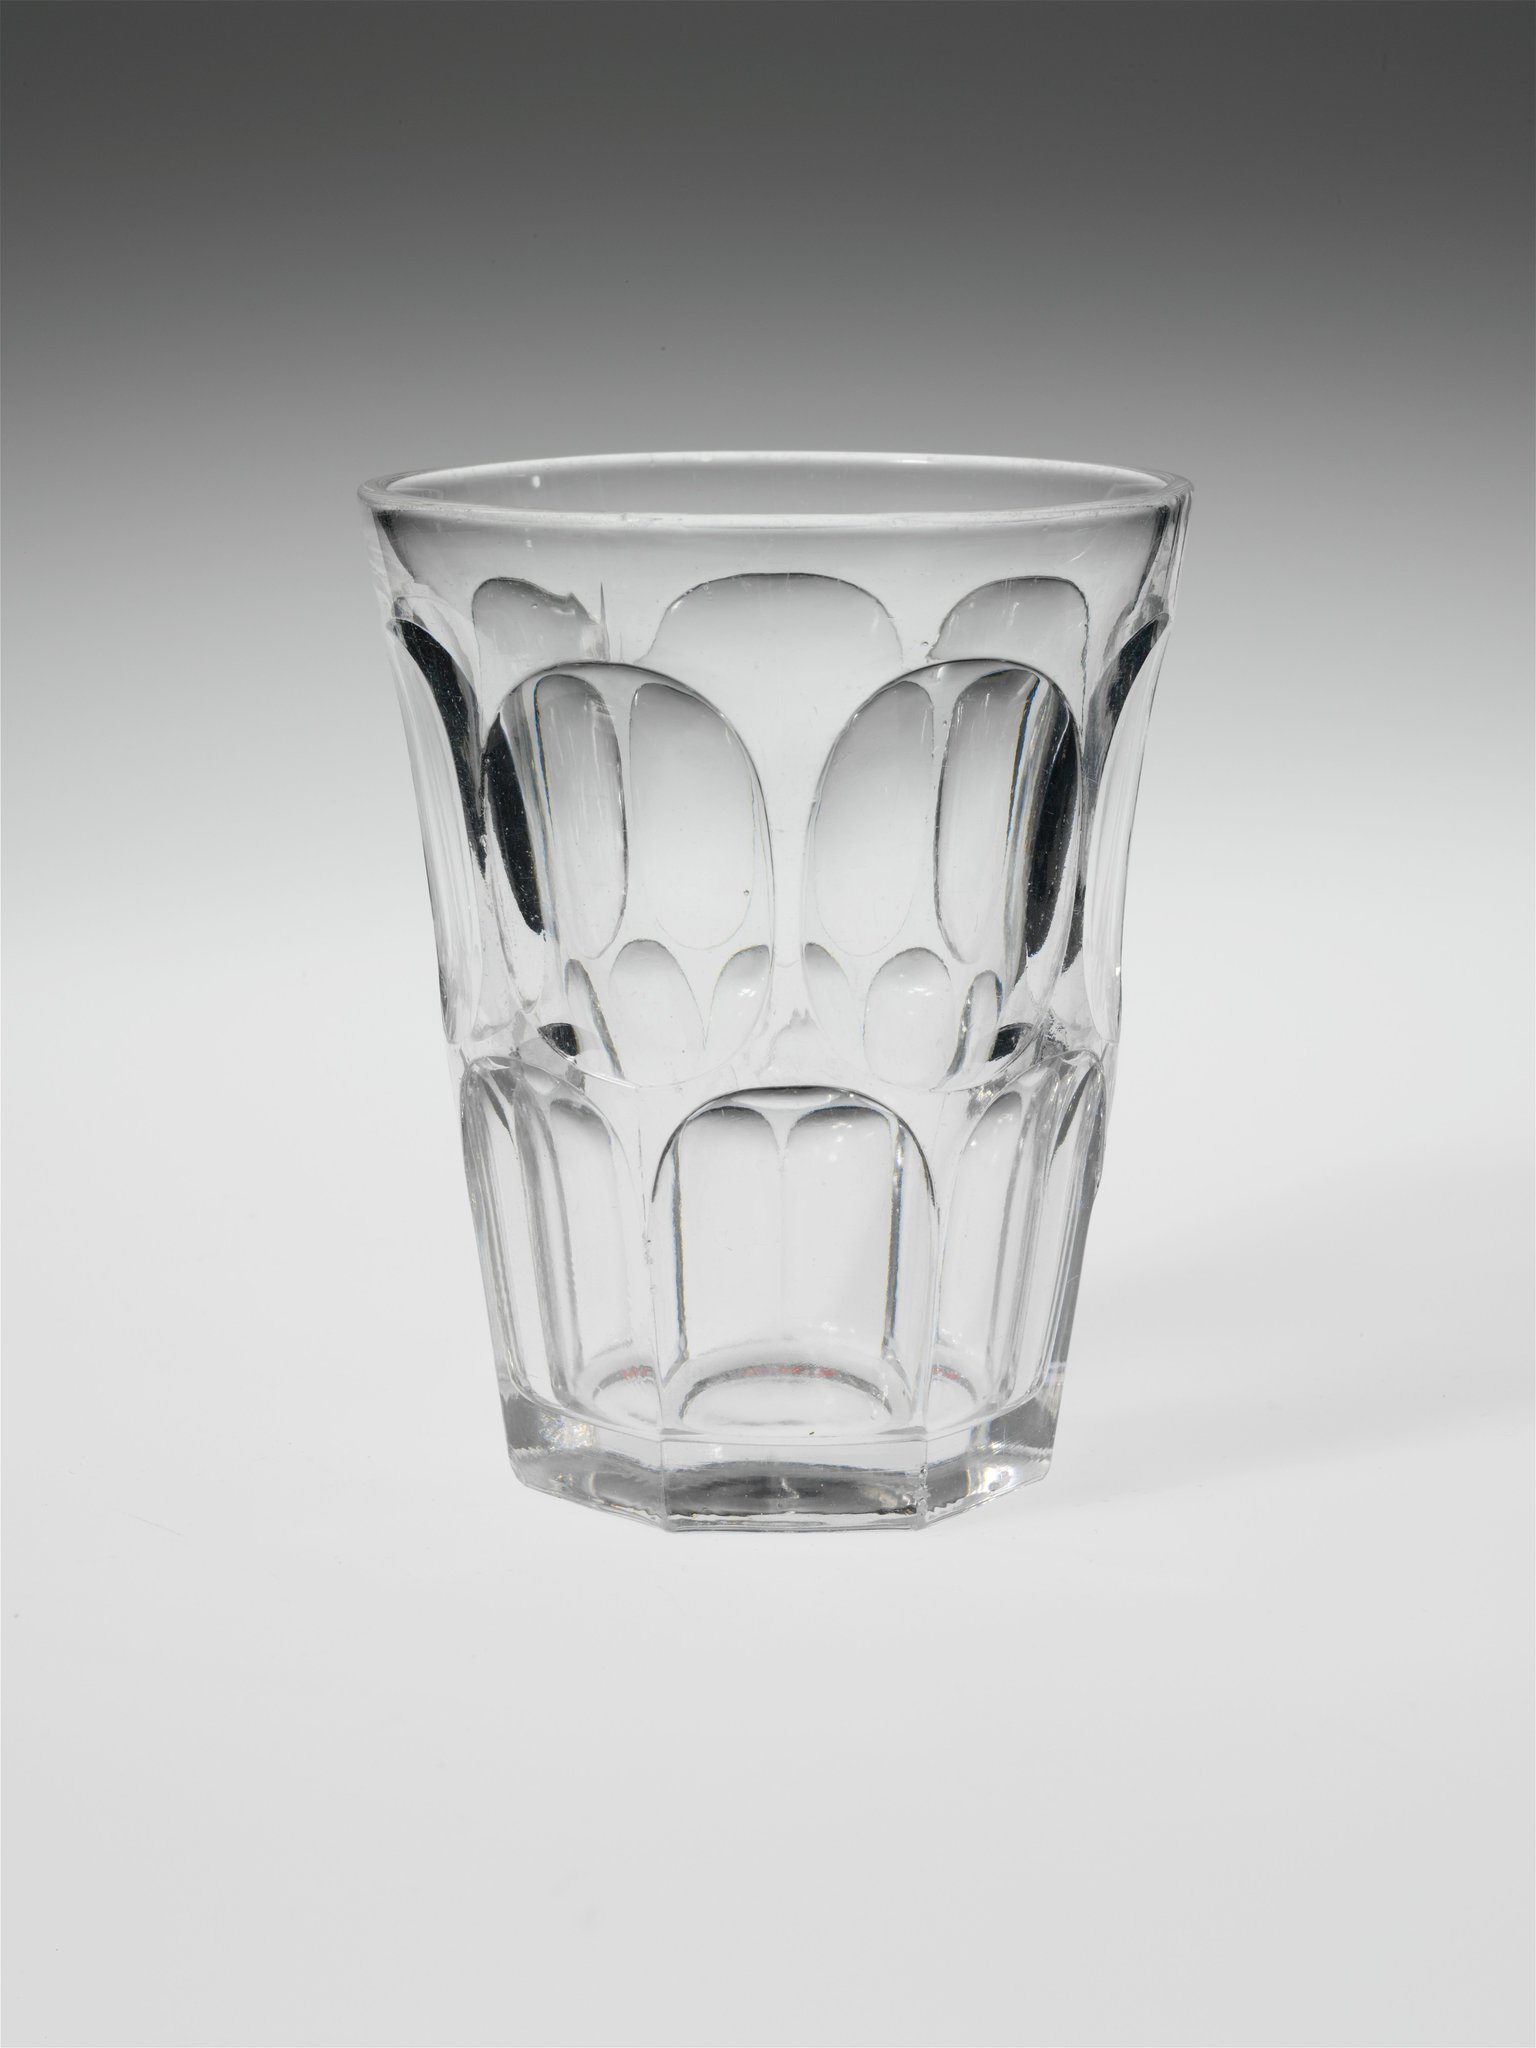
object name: flip glass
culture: american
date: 1830-1870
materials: glass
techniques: pressed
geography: united states